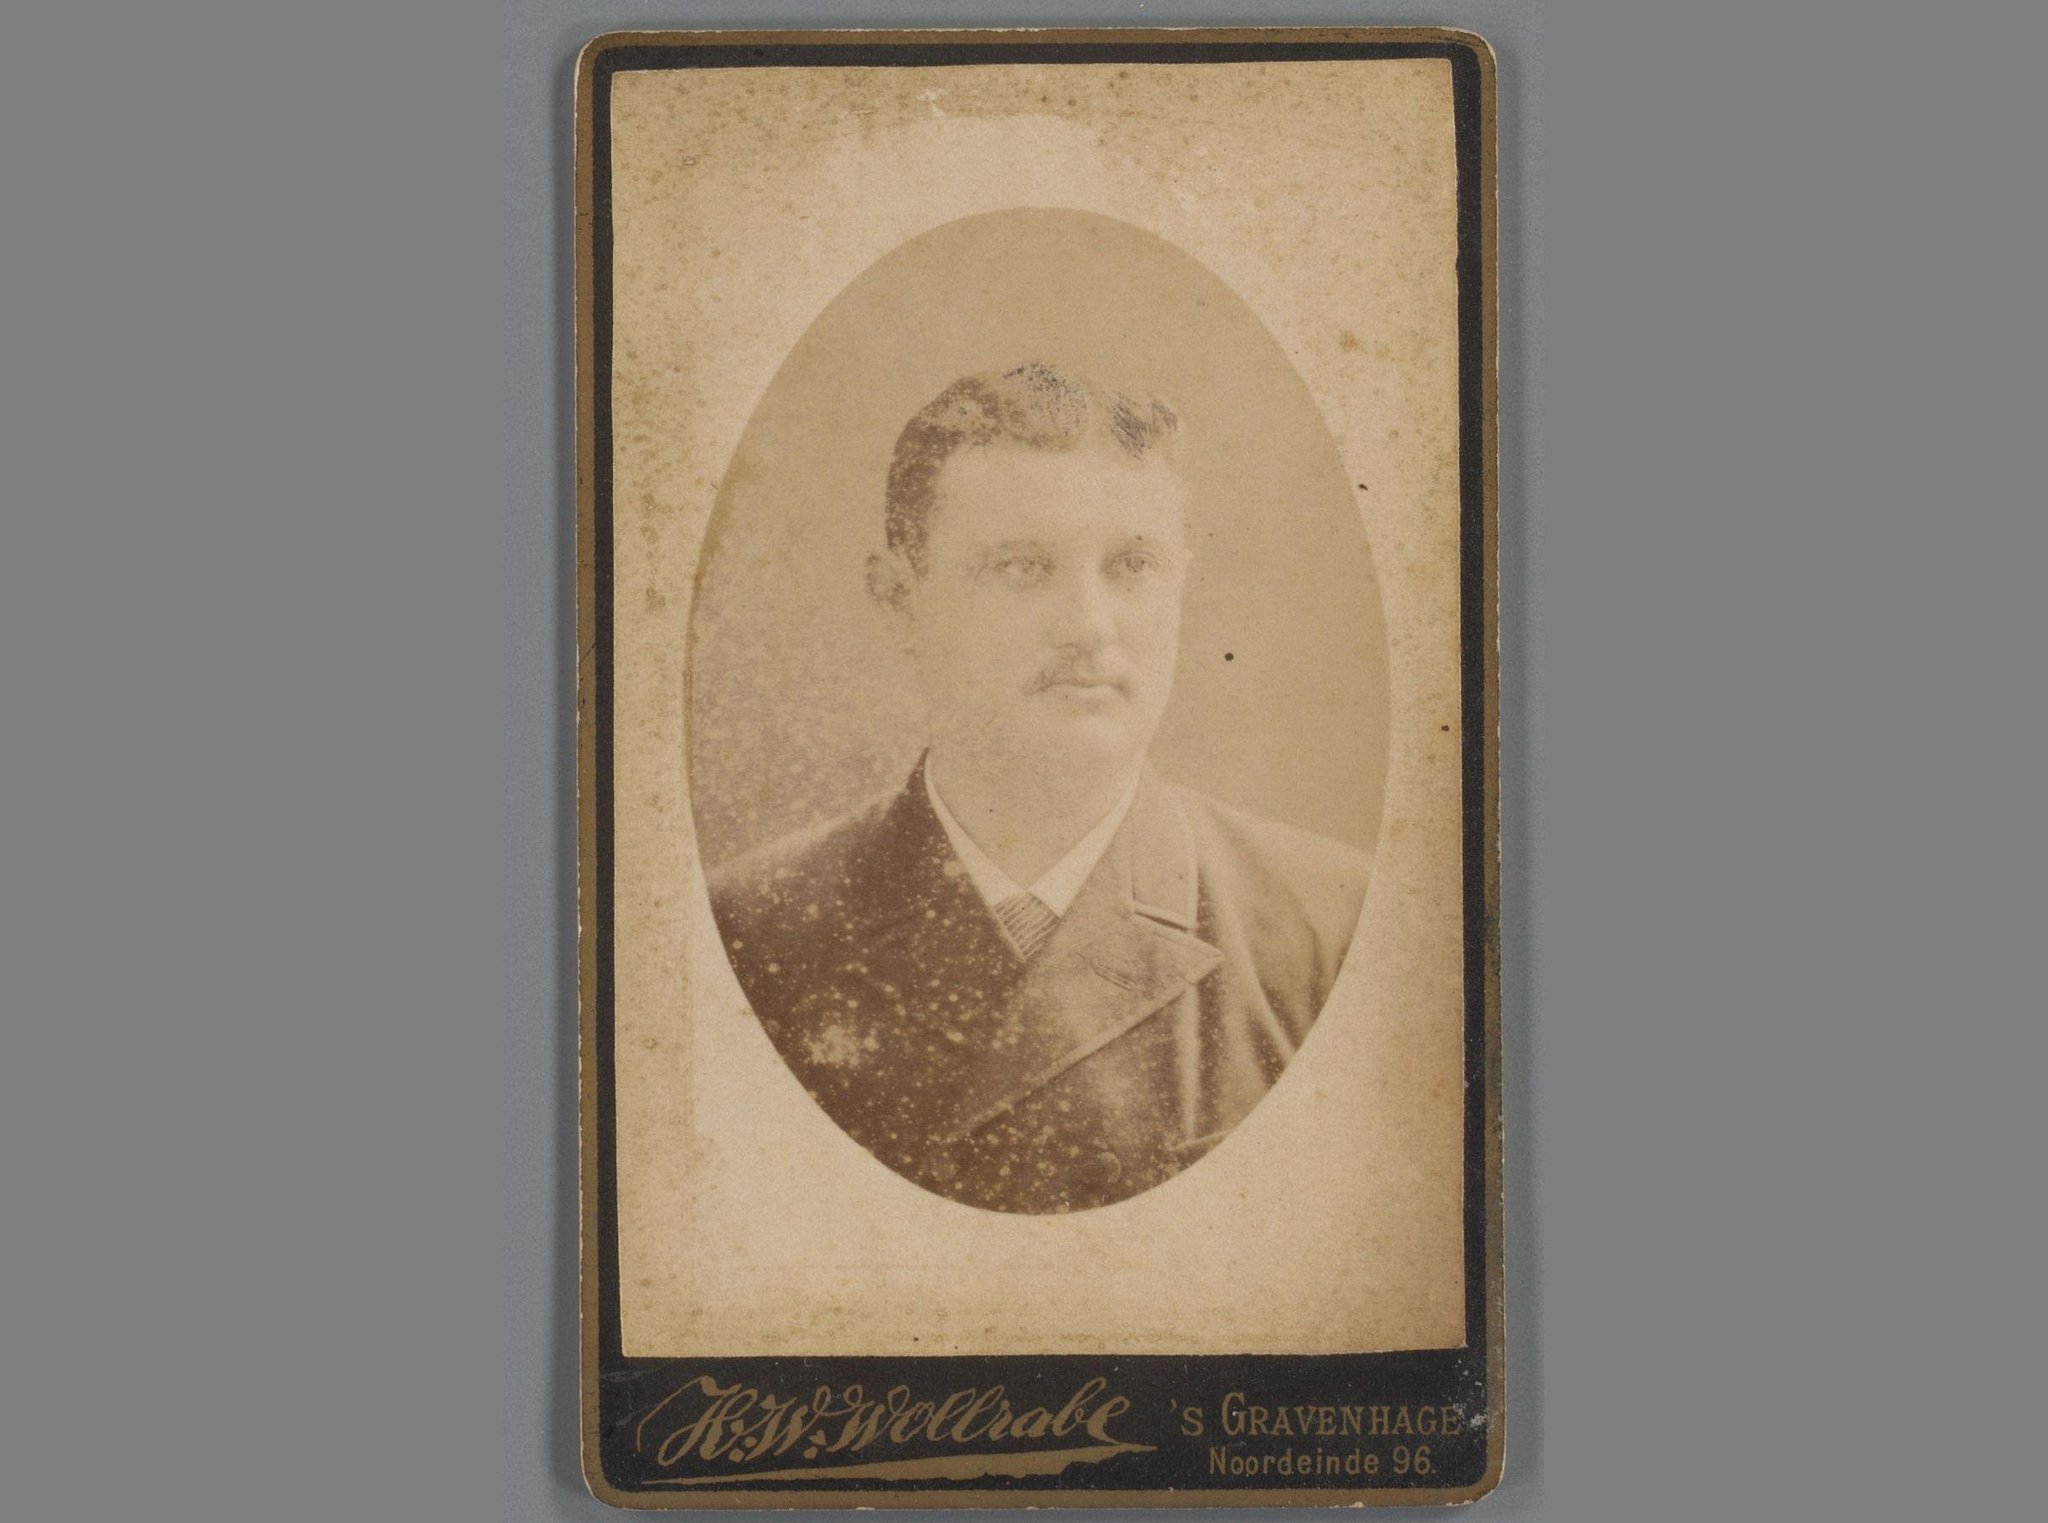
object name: photograph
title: Portret van een onbekende man, mogelijk een lid van de familie Onnen-van den Berg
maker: heinrich wilhelm wollrabe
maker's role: fotograaf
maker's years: 1843-1928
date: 1877-1910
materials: cardboard, paper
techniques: albumen print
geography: the hague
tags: anonymous historical person portrayed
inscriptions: address: ‘96. Noordeinde 96/ 's Gravenhage’